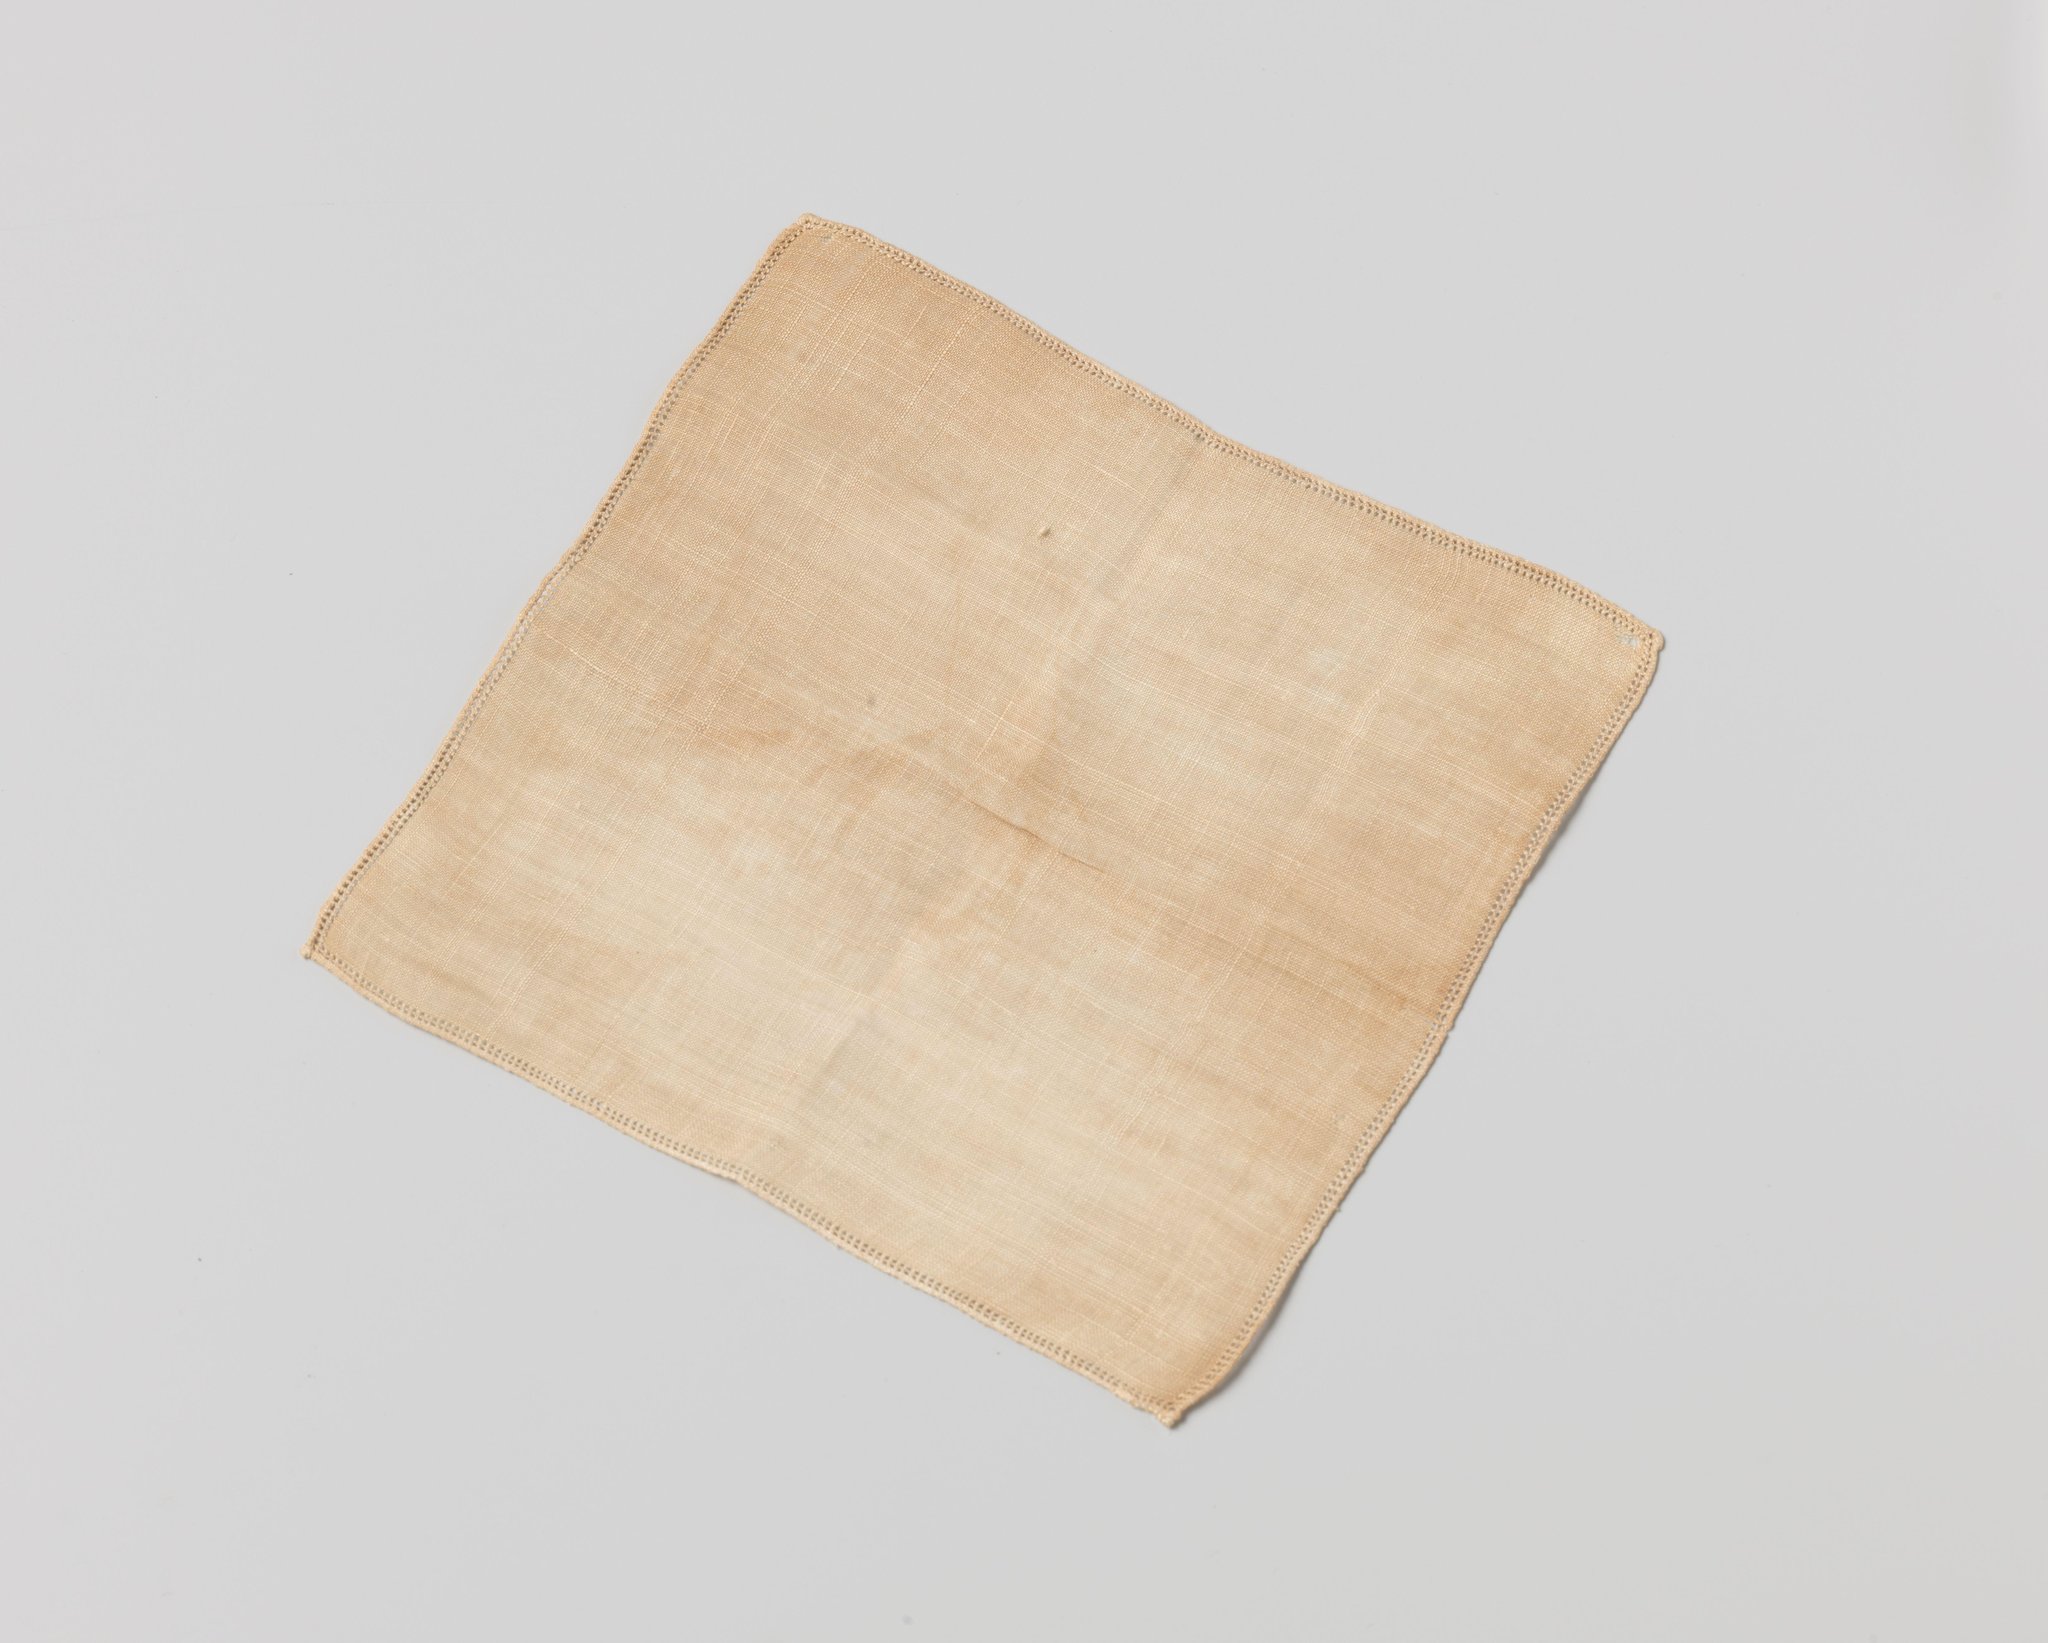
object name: miniature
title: Tafelkleed met opengewerkte zoom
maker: Anonymous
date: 1700-1799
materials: linen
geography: netherlands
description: Een fijnlinnen tafelkleed met opengewerkte zoom.